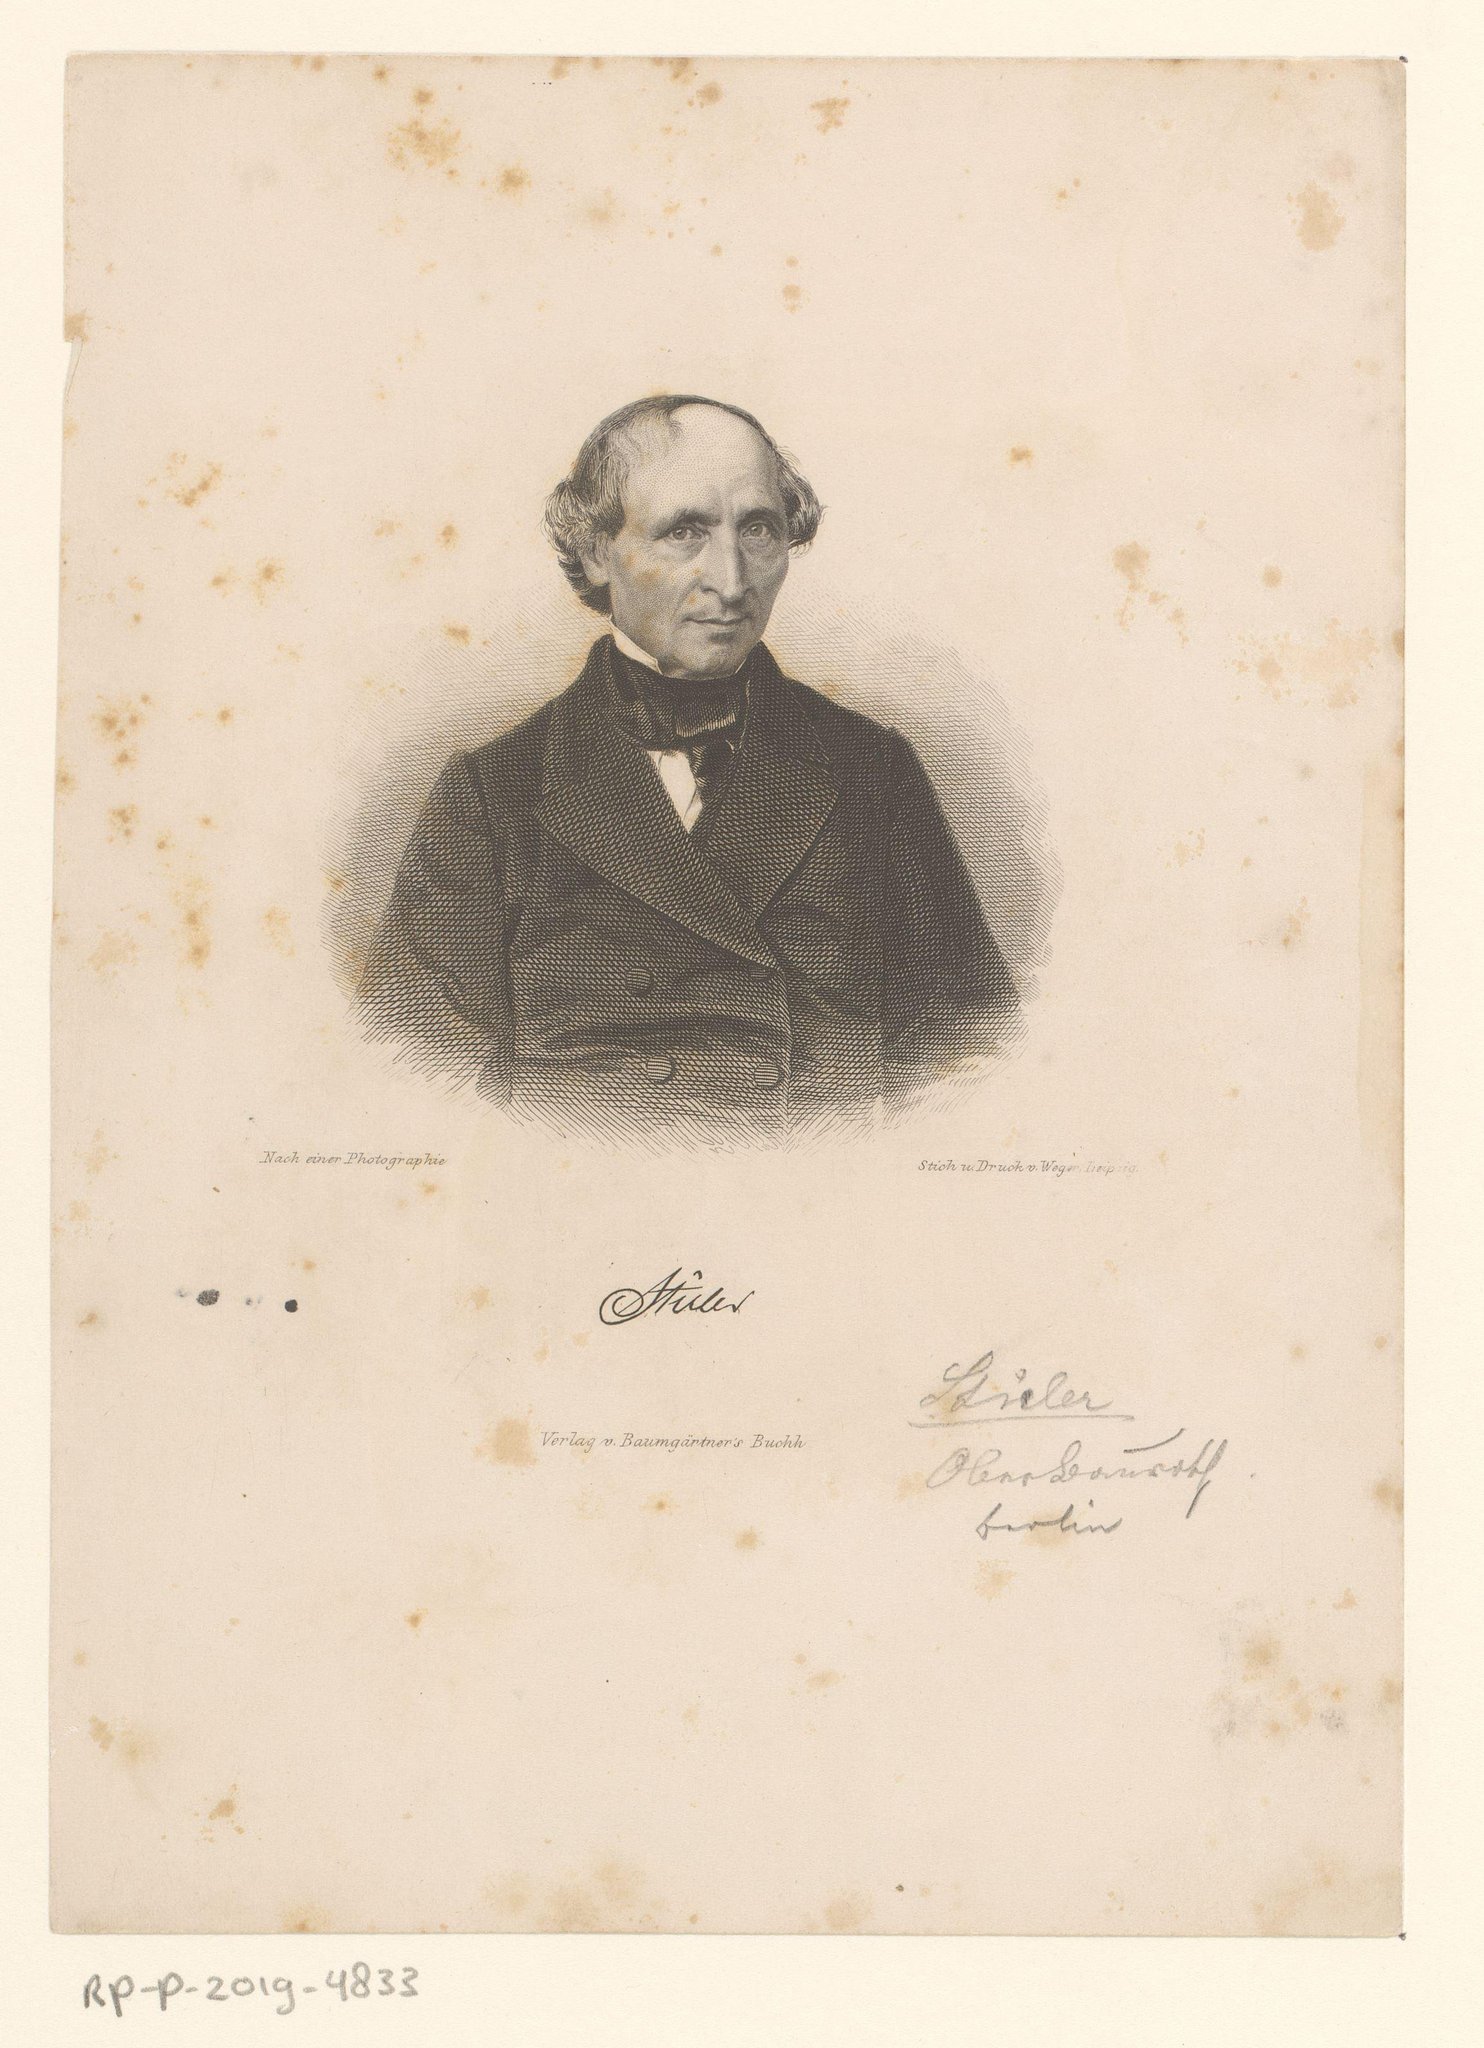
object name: print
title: Portret van Friedrich August Stüler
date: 1863-1892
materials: paper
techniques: etching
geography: leipzig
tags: friedrich august stüler, historical persons, portrait, self-portrait of architect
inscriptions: collector's mark: Lugt 2760, collector's mark: Lugt 2228, collector's mark: ‘Franz Radestom [?]’